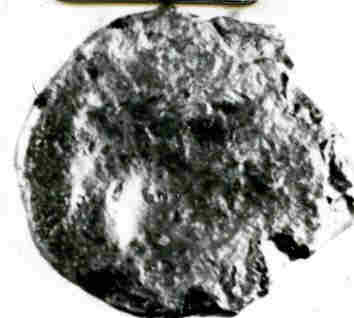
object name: coin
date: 401-1400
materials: copper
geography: iran